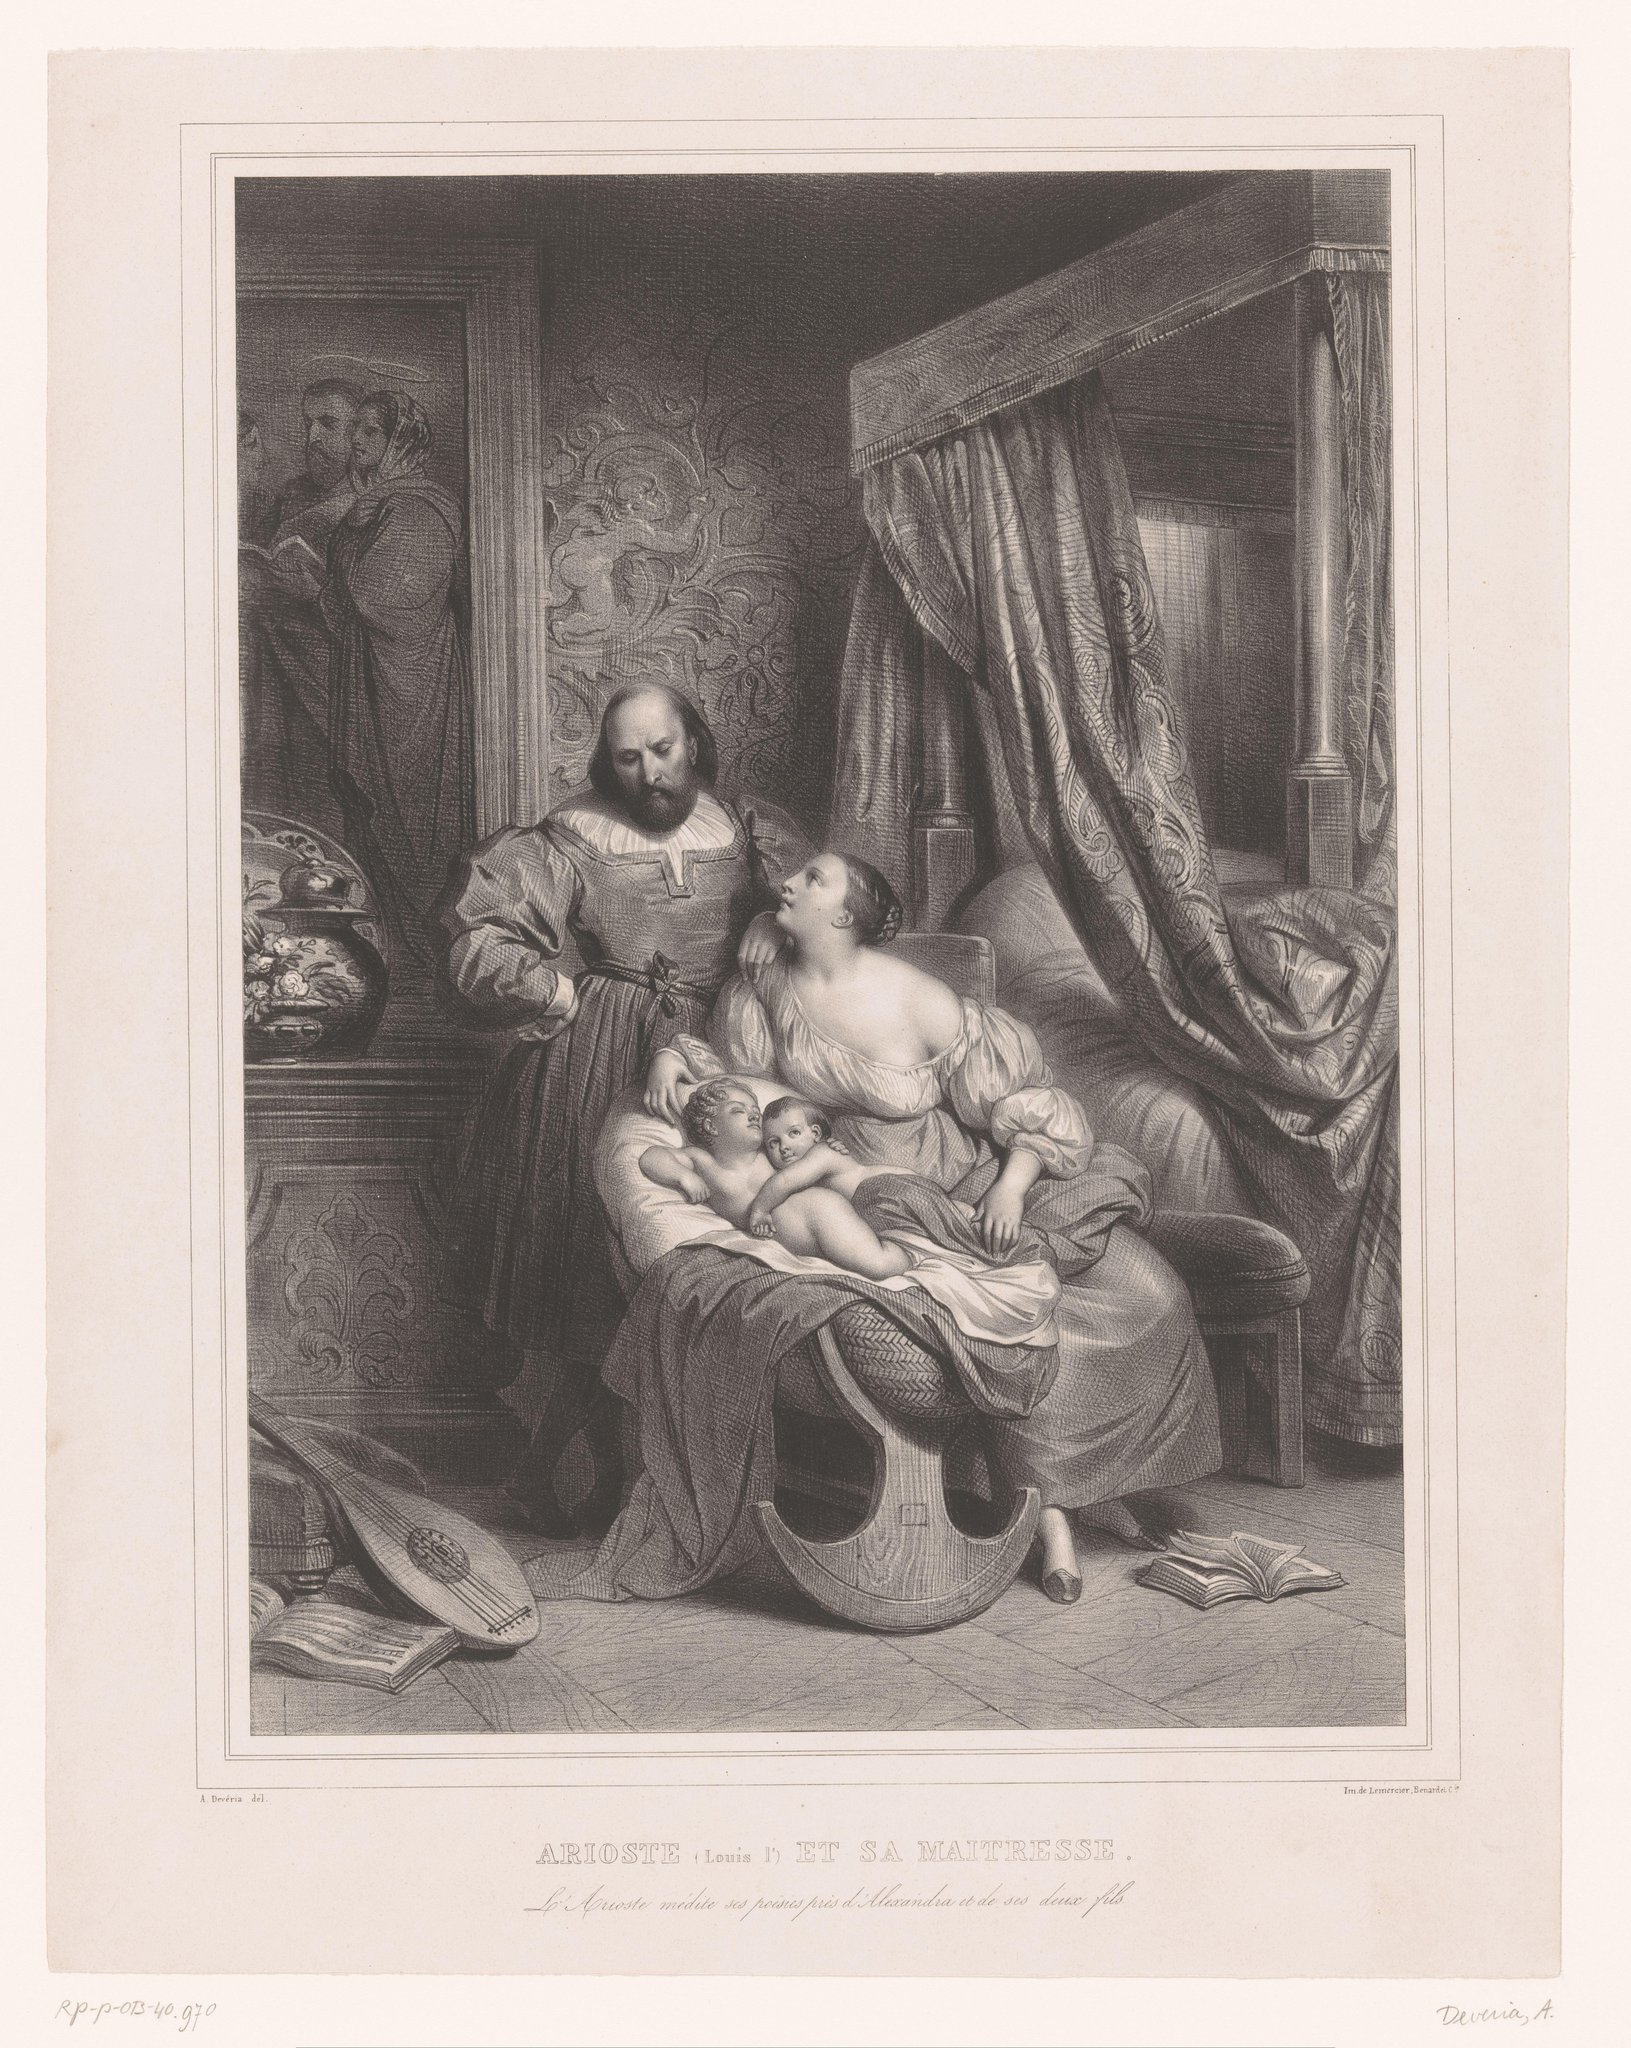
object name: print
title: Ludovico Ariosto met zijn maîtresse en twee zoons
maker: achille devéria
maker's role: draughtsman, painter, print maker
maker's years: 1800-1857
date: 1838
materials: paper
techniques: lithograph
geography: paris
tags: ludovico ariosto, parents with their children, historical persons